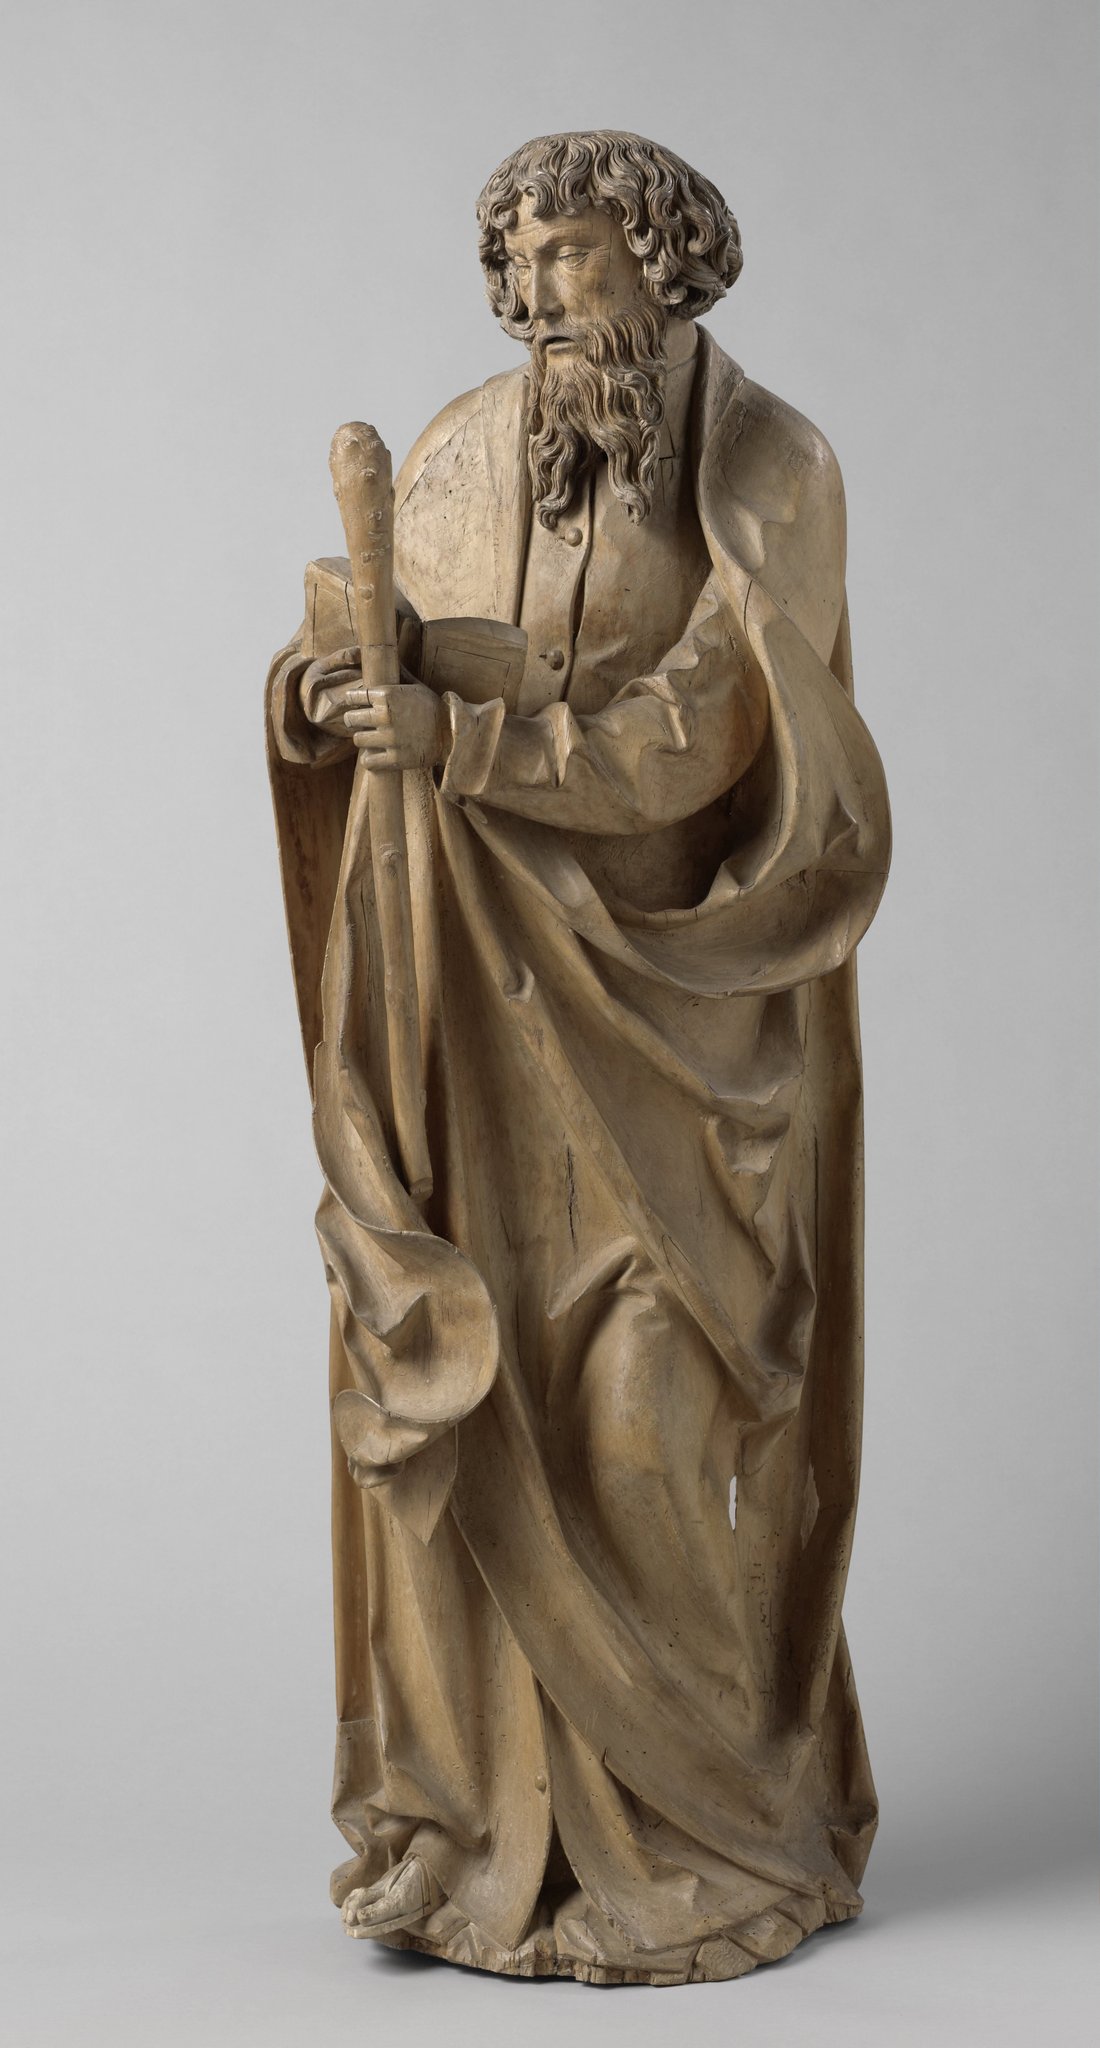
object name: figure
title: De apostel Judas Thaddeus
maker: Anonymous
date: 1515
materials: wood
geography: austria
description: St Jude. Limewood, originally with polychromy. Austria or Southern Germany, c. 1515.